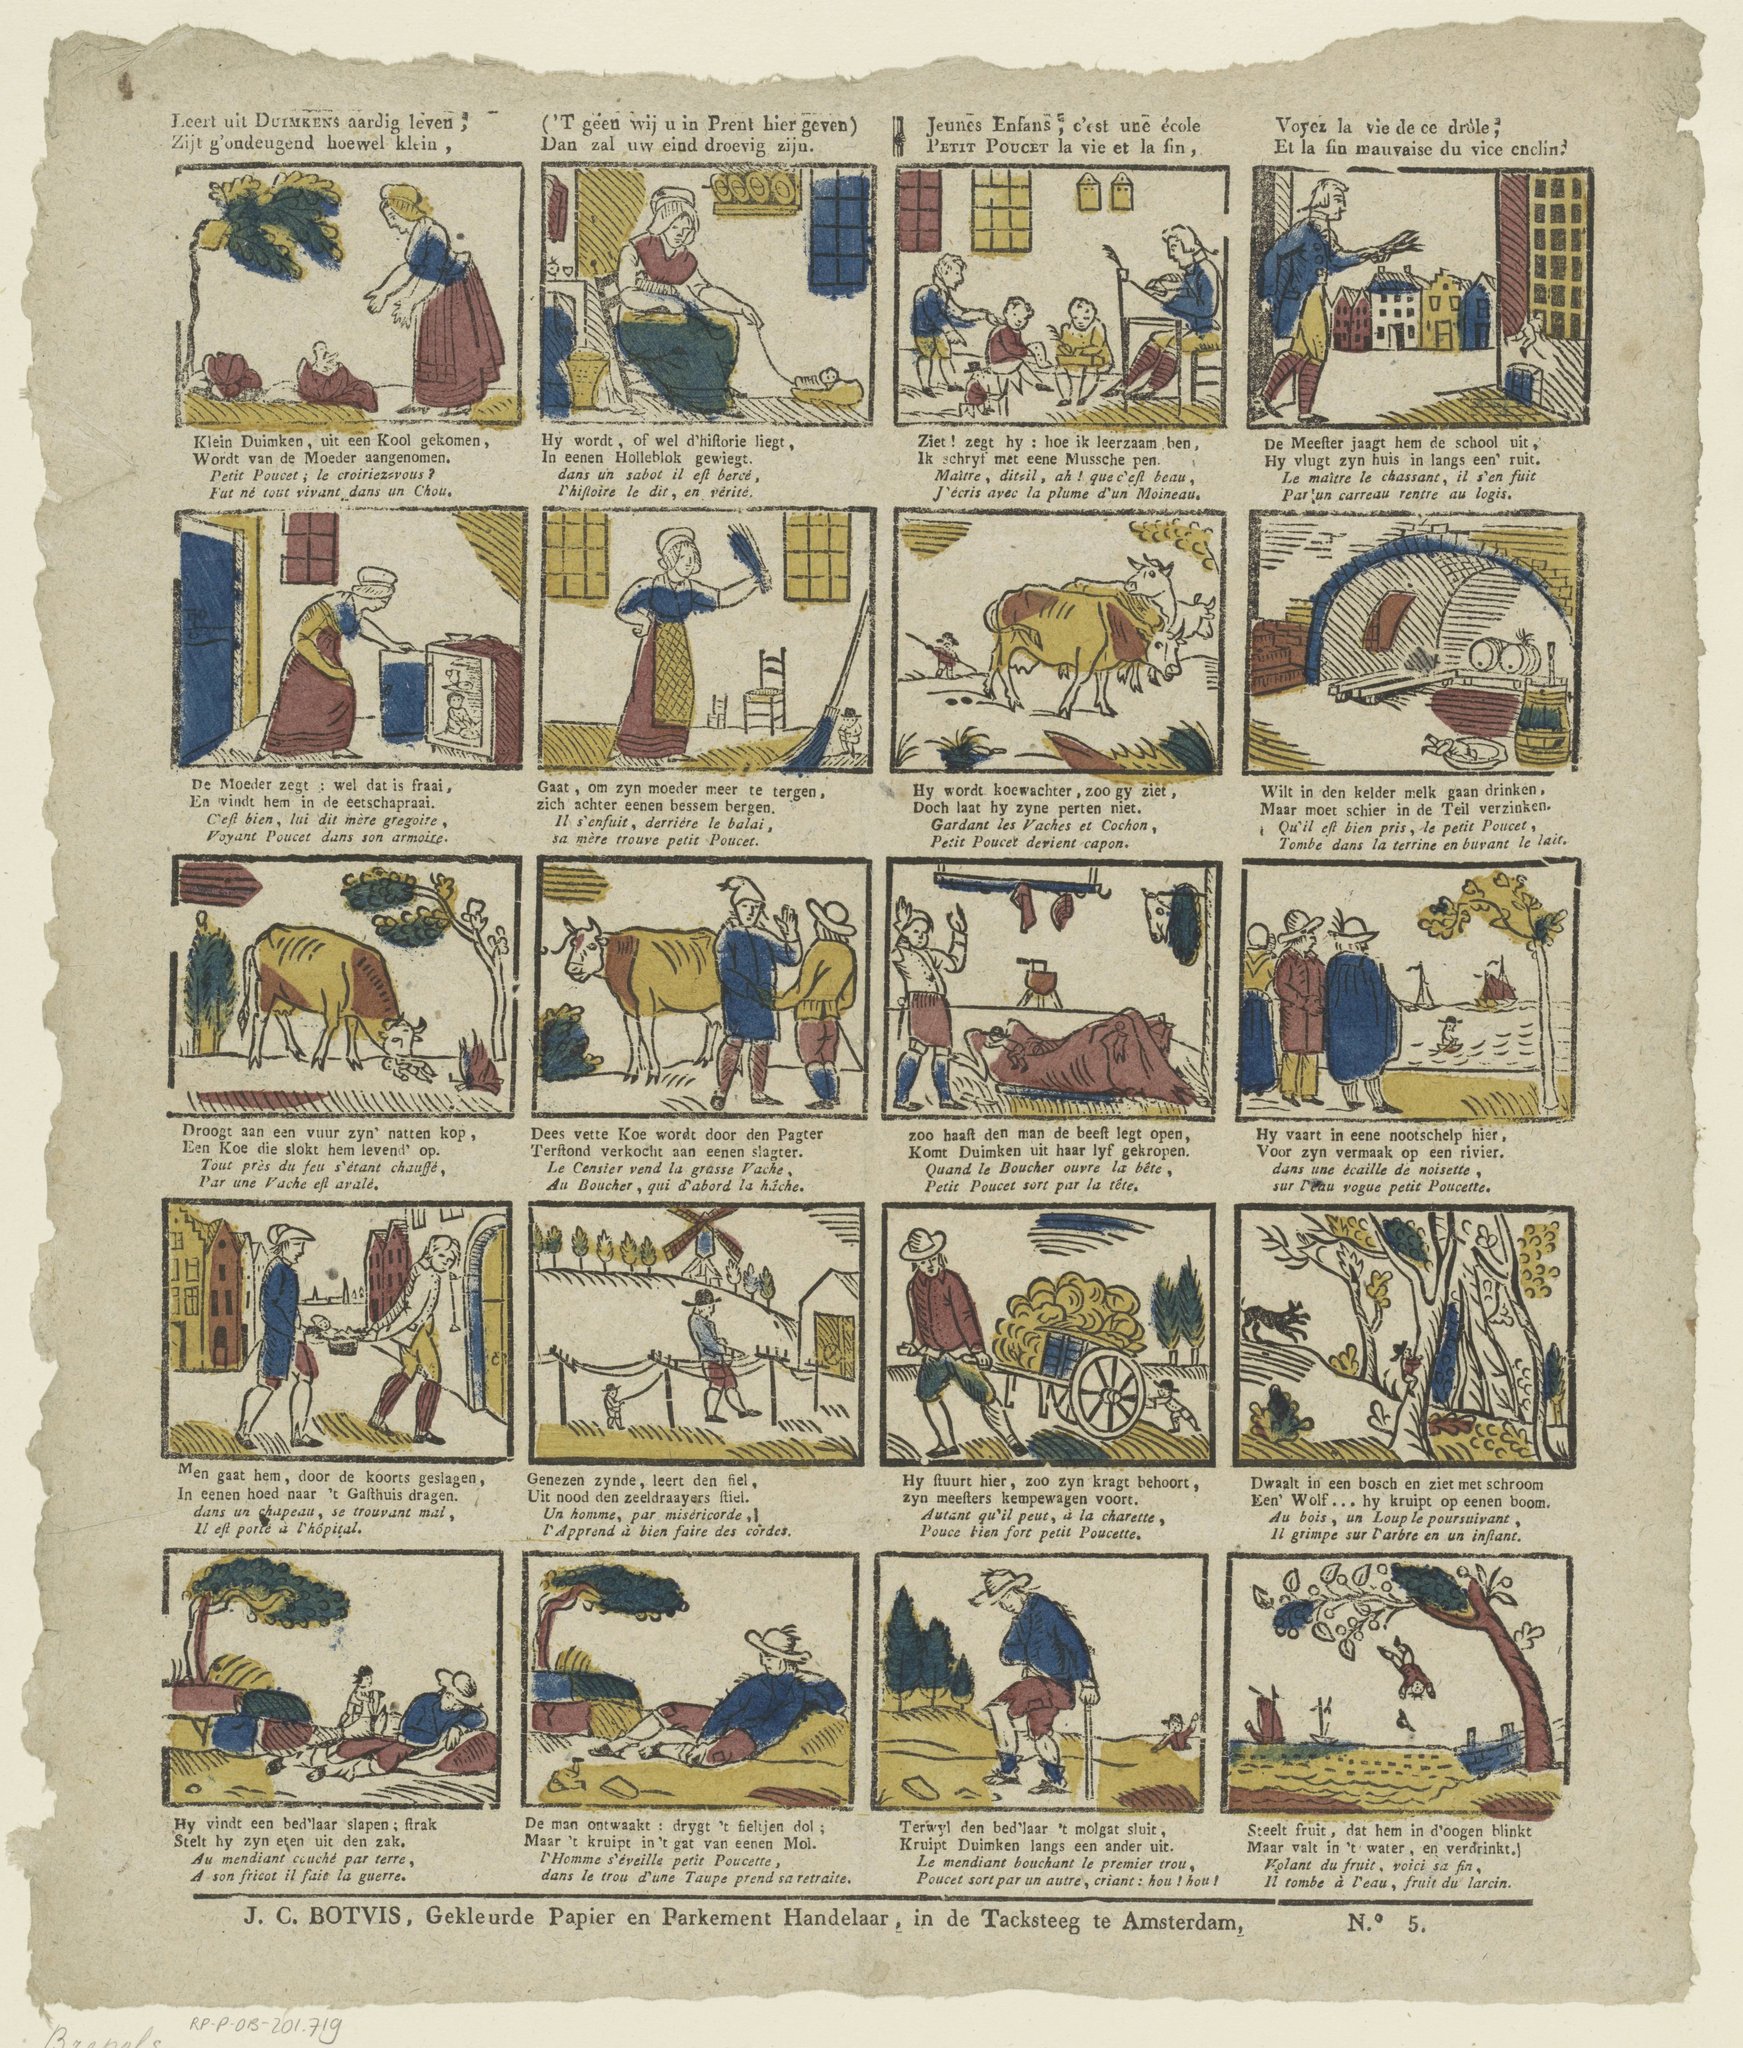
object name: print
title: Leert uyt Duimkens aardig leven, / ('T geen wij in prent hier geven) / Zijt g'ondeugend hoewel klein, / Dan zal uw eind droevig zijn / Jeunes enfans, c'est une école / Voyez la vie de ce drôle / Petit Poucet la vie et la fin. / Et la fin mauvaise du vice enclin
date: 1800-1833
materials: paper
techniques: colour, letterpress printing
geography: amsterdam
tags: tales and fairy tales, tales and fairy tales: little thumbling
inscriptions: collector's mark: Lugt 2760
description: Blad met 2 voorstellingen uit het verhaal van Klein Duimpje. Onder elke voorstelling een tweeregelig vers in het Nederlands en in het Frans. Genummerd linksonder: No. 5.